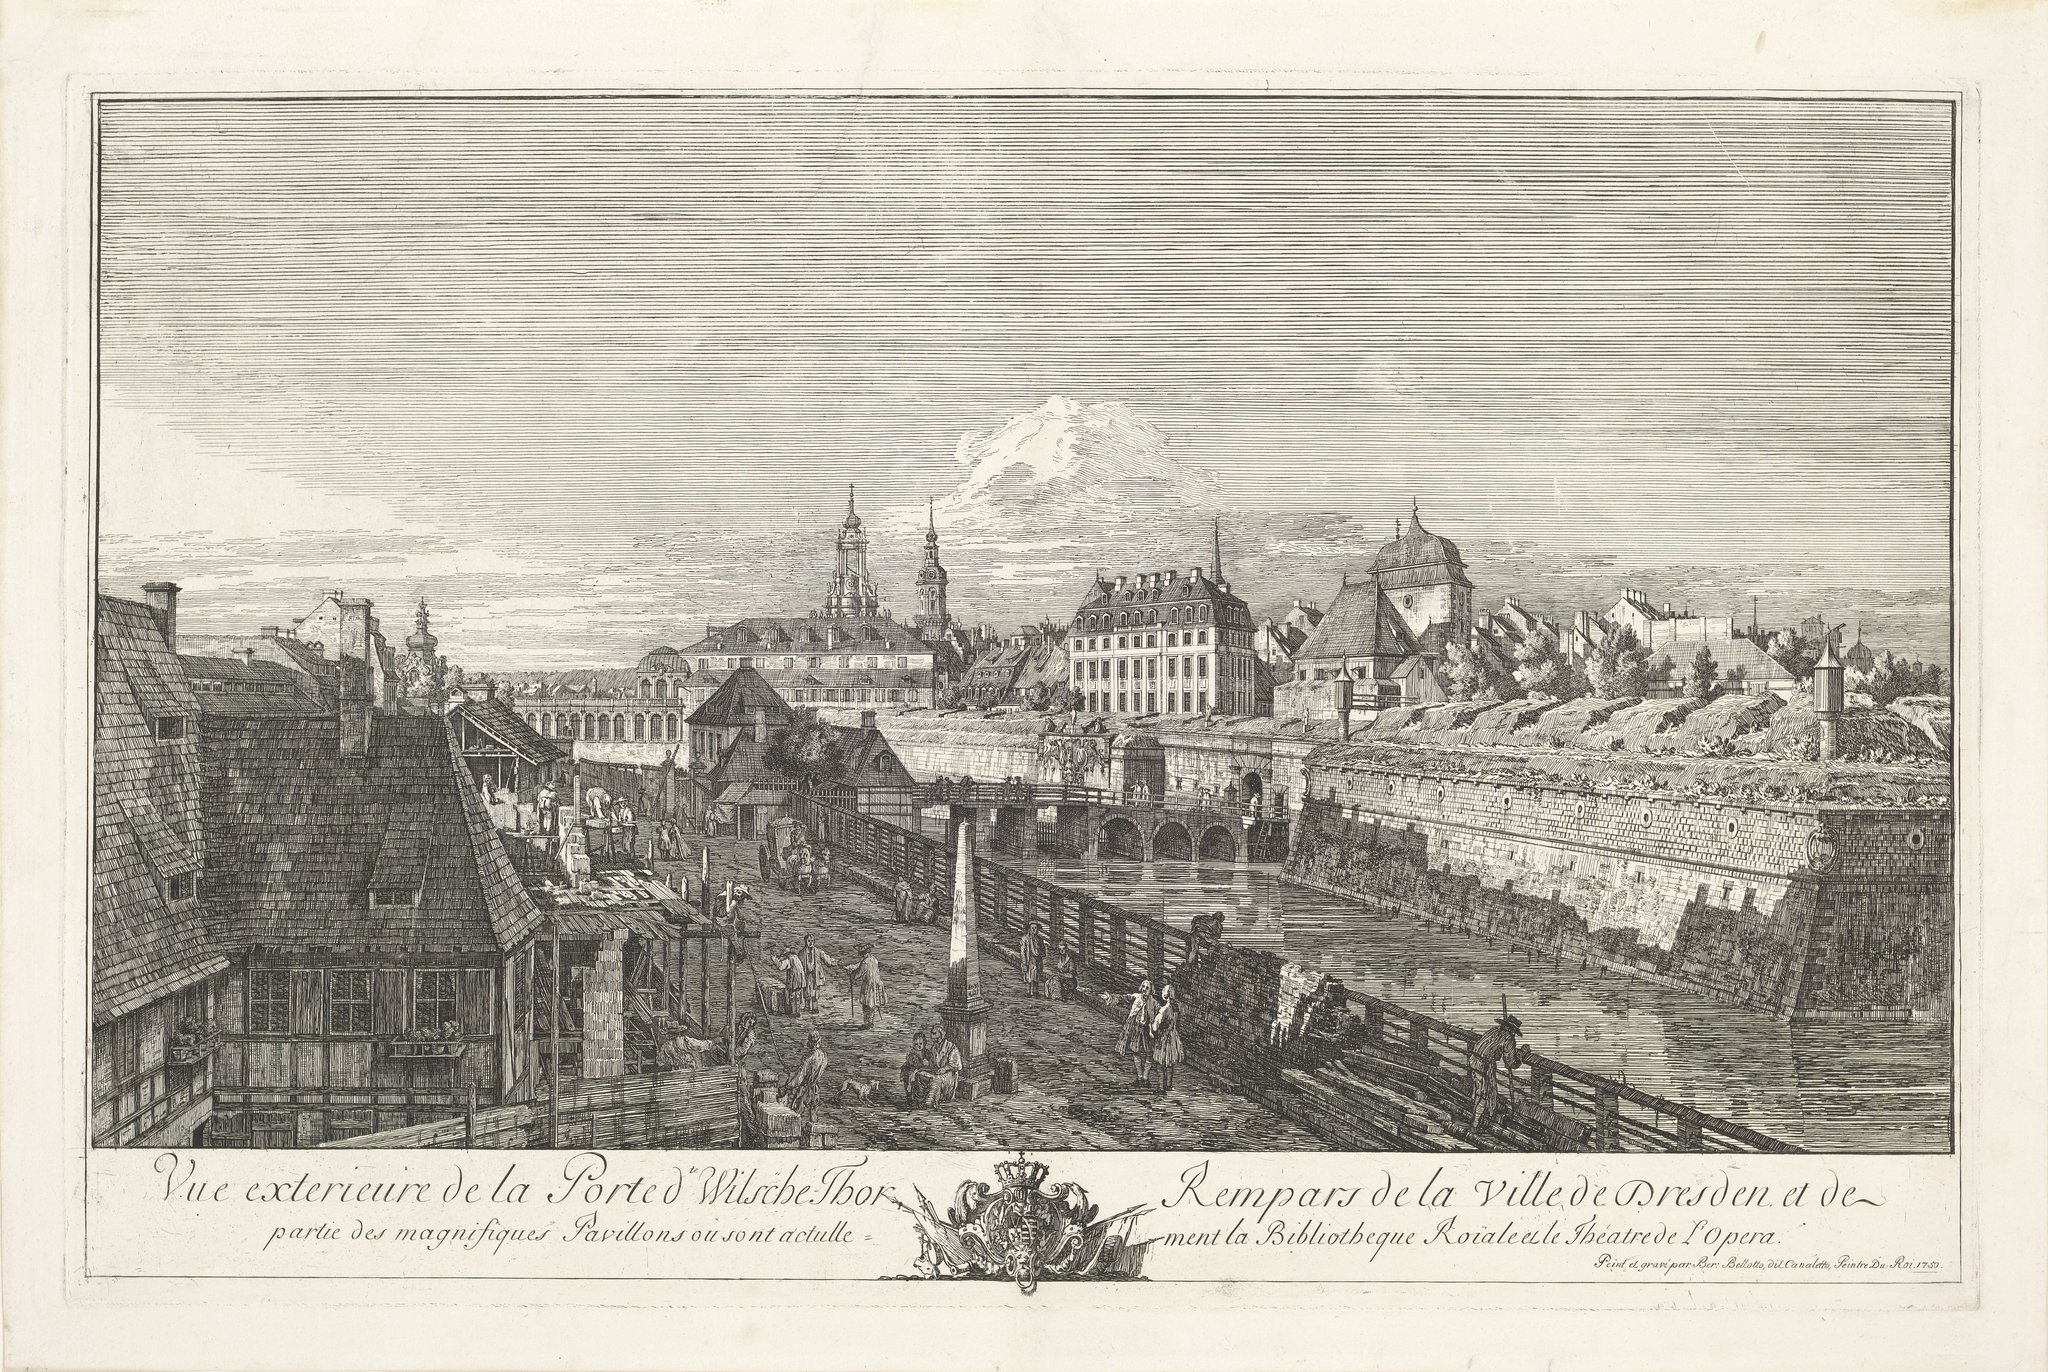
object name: print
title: Gezicht vanaf de Wilschenpoort met de koninklijke bibliotheek te Dresden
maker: bernardo bellotto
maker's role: draughtsman, painter, print maker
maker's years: 1721-1780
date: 1750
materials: paper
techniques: etching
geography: dresden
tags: city-view, and landscape with man-made constructions, city-view in general; 'veduta', public library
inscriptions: collector's mark: Lugt 2760, collector's mark: Lugt 2228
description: Gezicht vanaf de Wilschenpoort met de koninklijke bibliotheek te Dresden. Wapen en titel in het Frans in ondermarge.